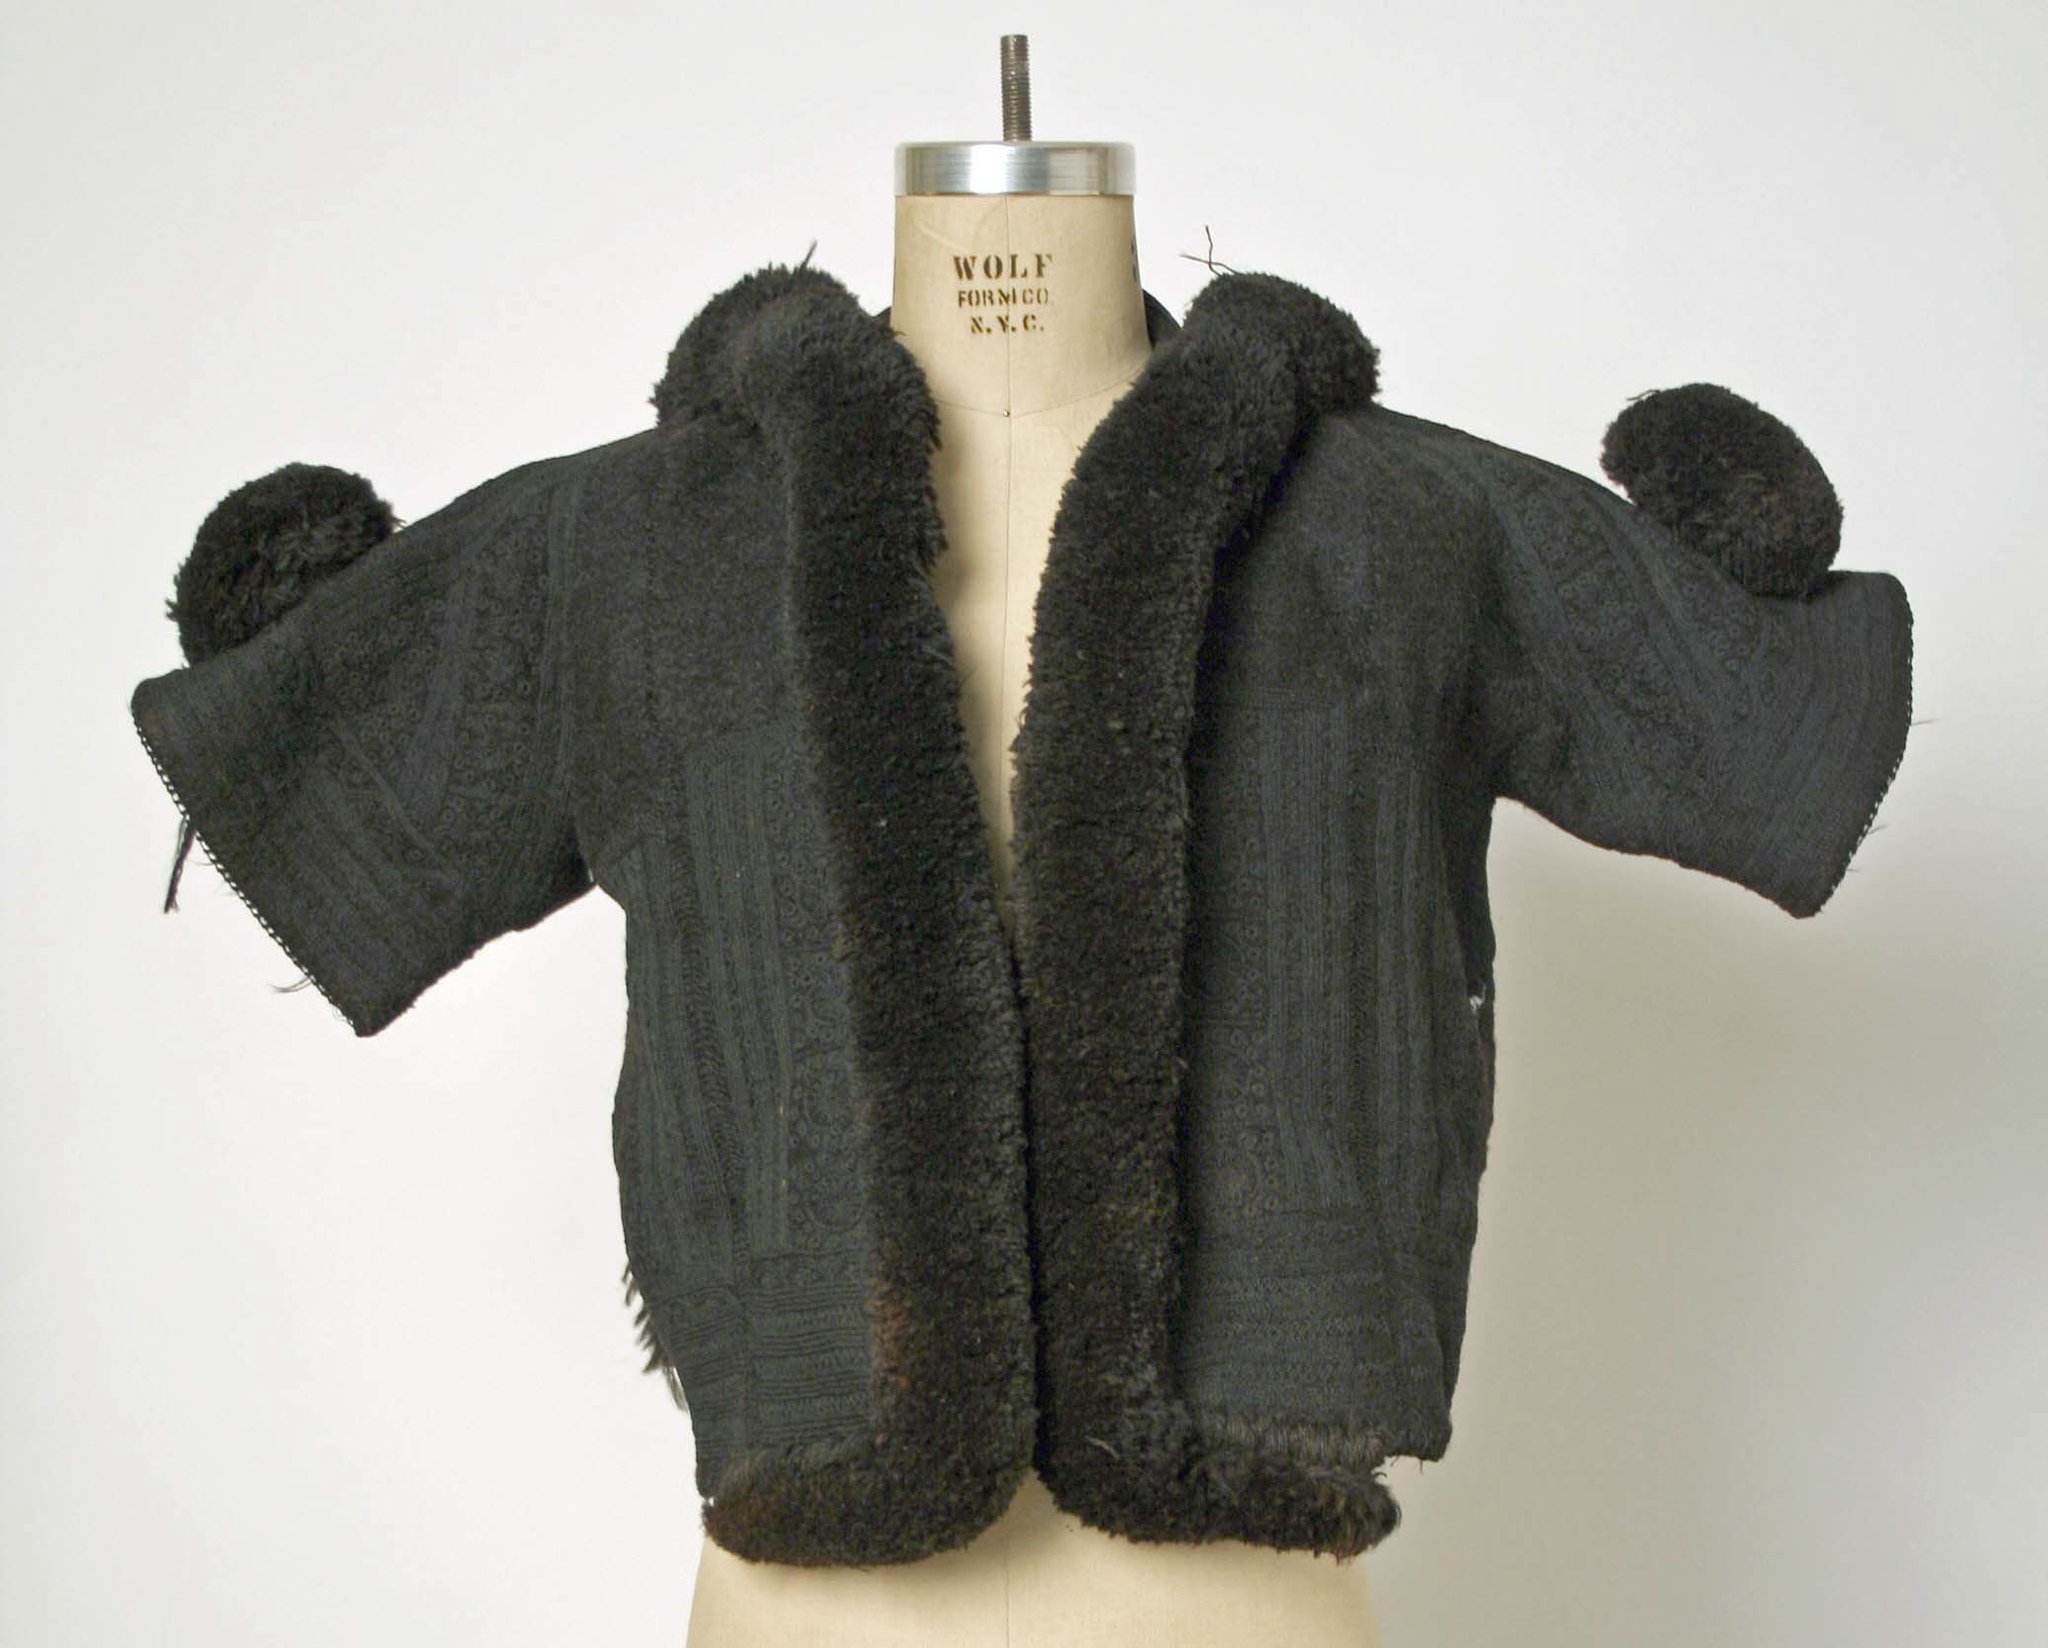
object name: ensemble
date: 1867-1933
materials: cotton, leather, silk, wool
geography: central